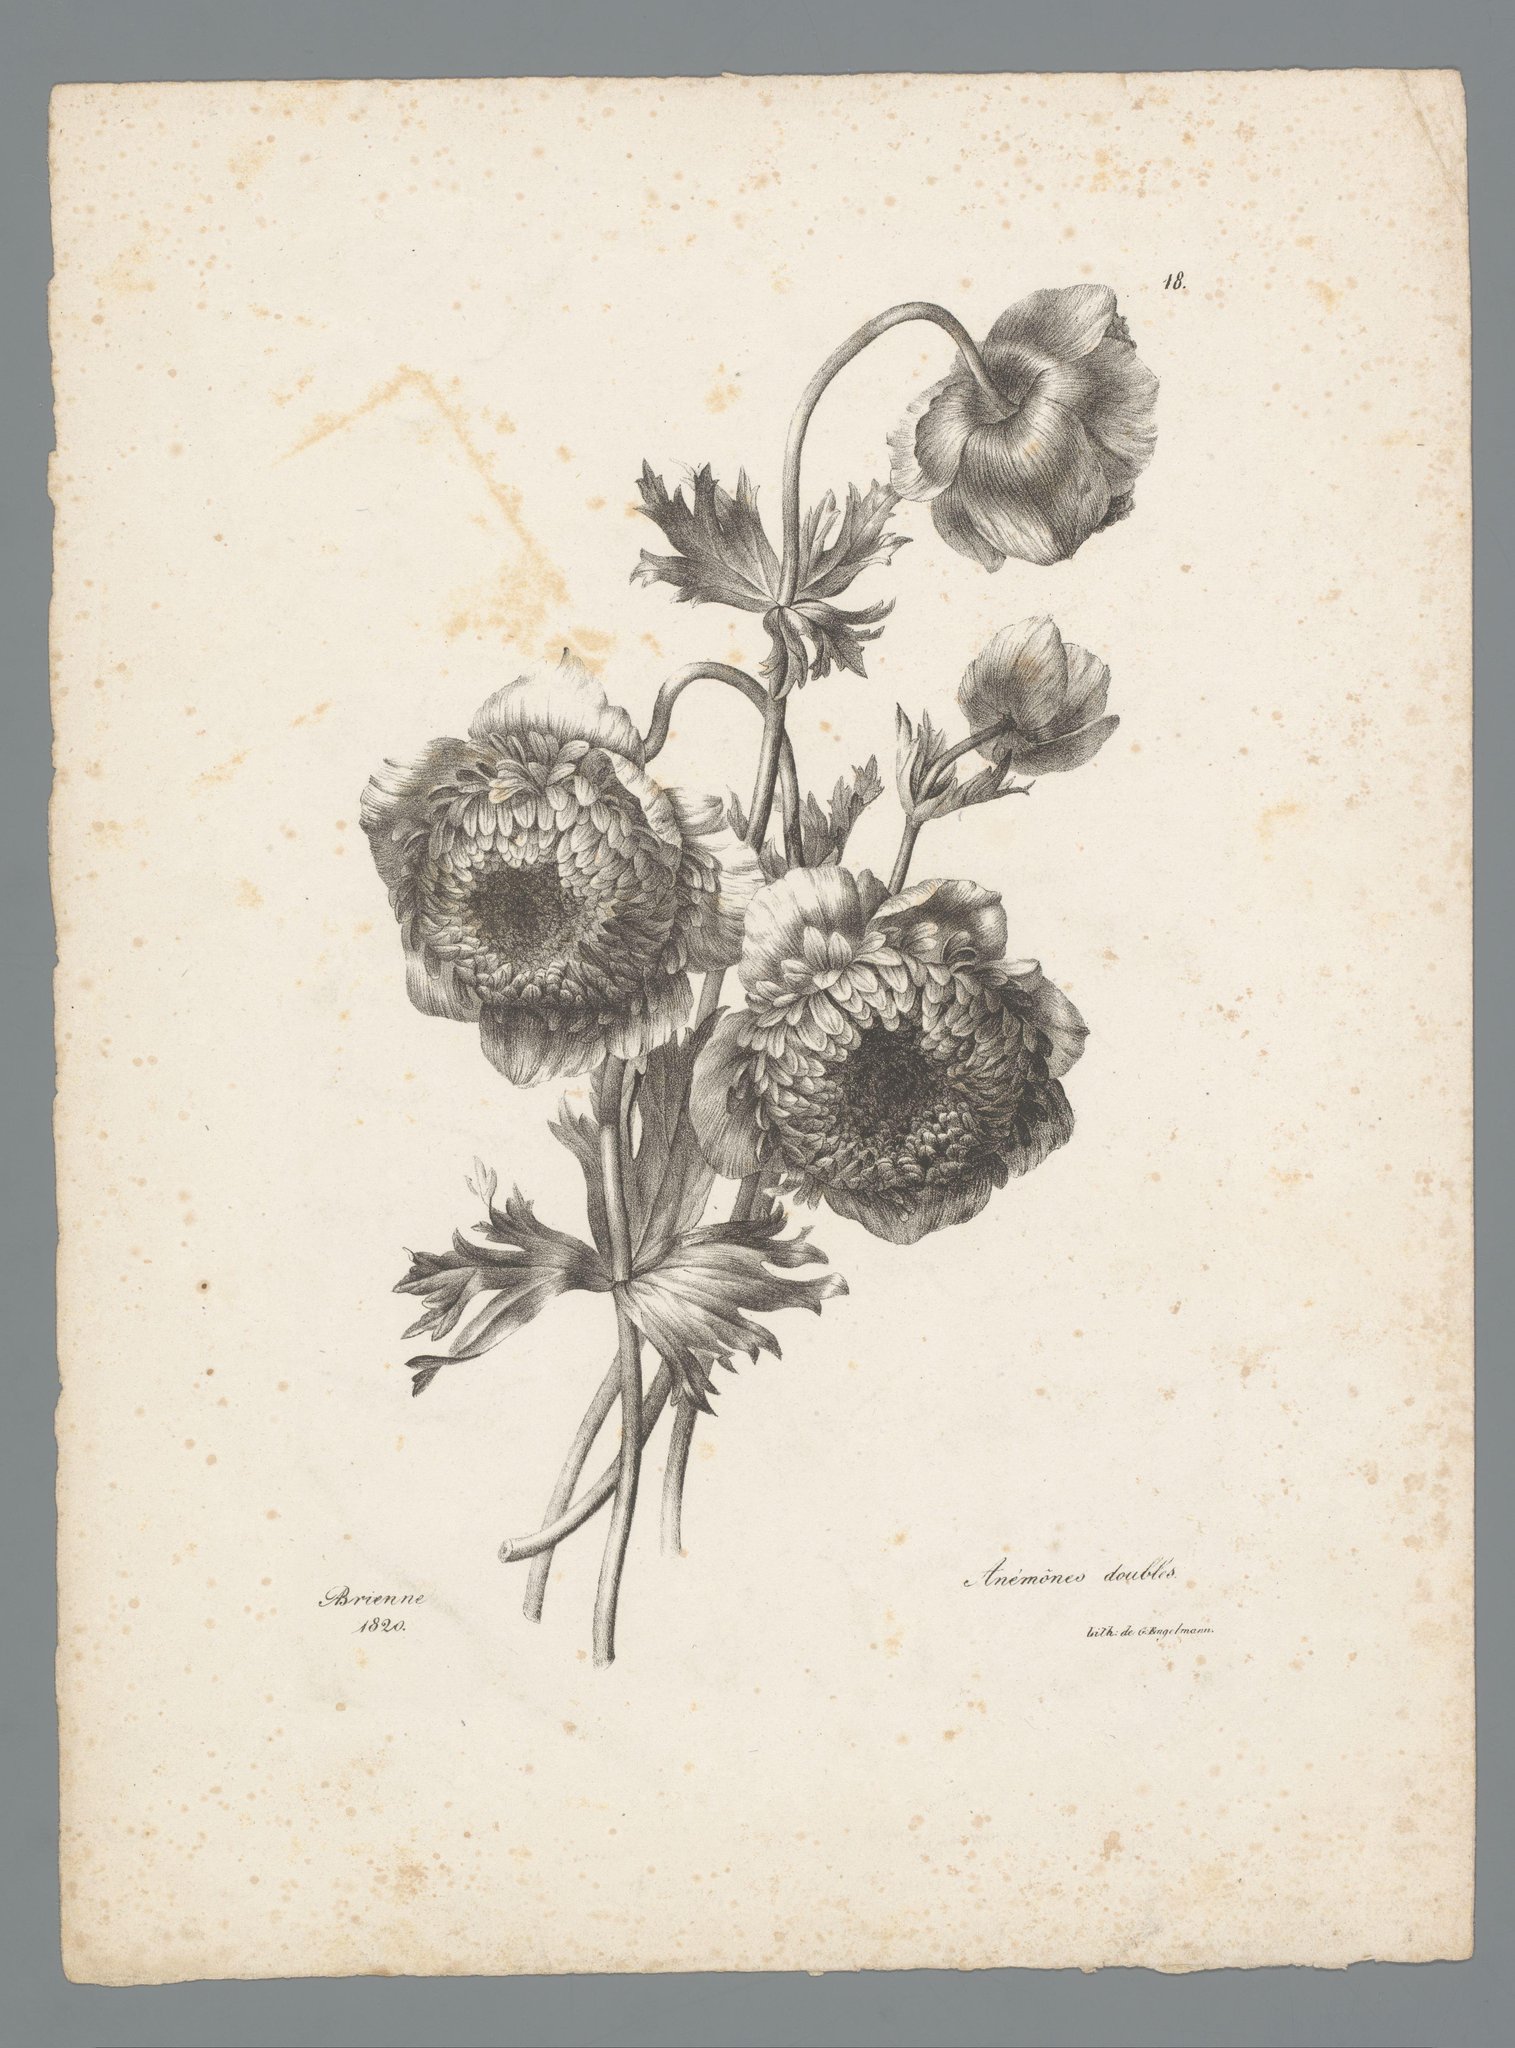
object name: print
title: Dubbele anemonen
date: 1820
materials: paper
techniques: lithograph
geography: paris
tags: flowers: anemone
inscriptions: collector's mark: Lugt 2233